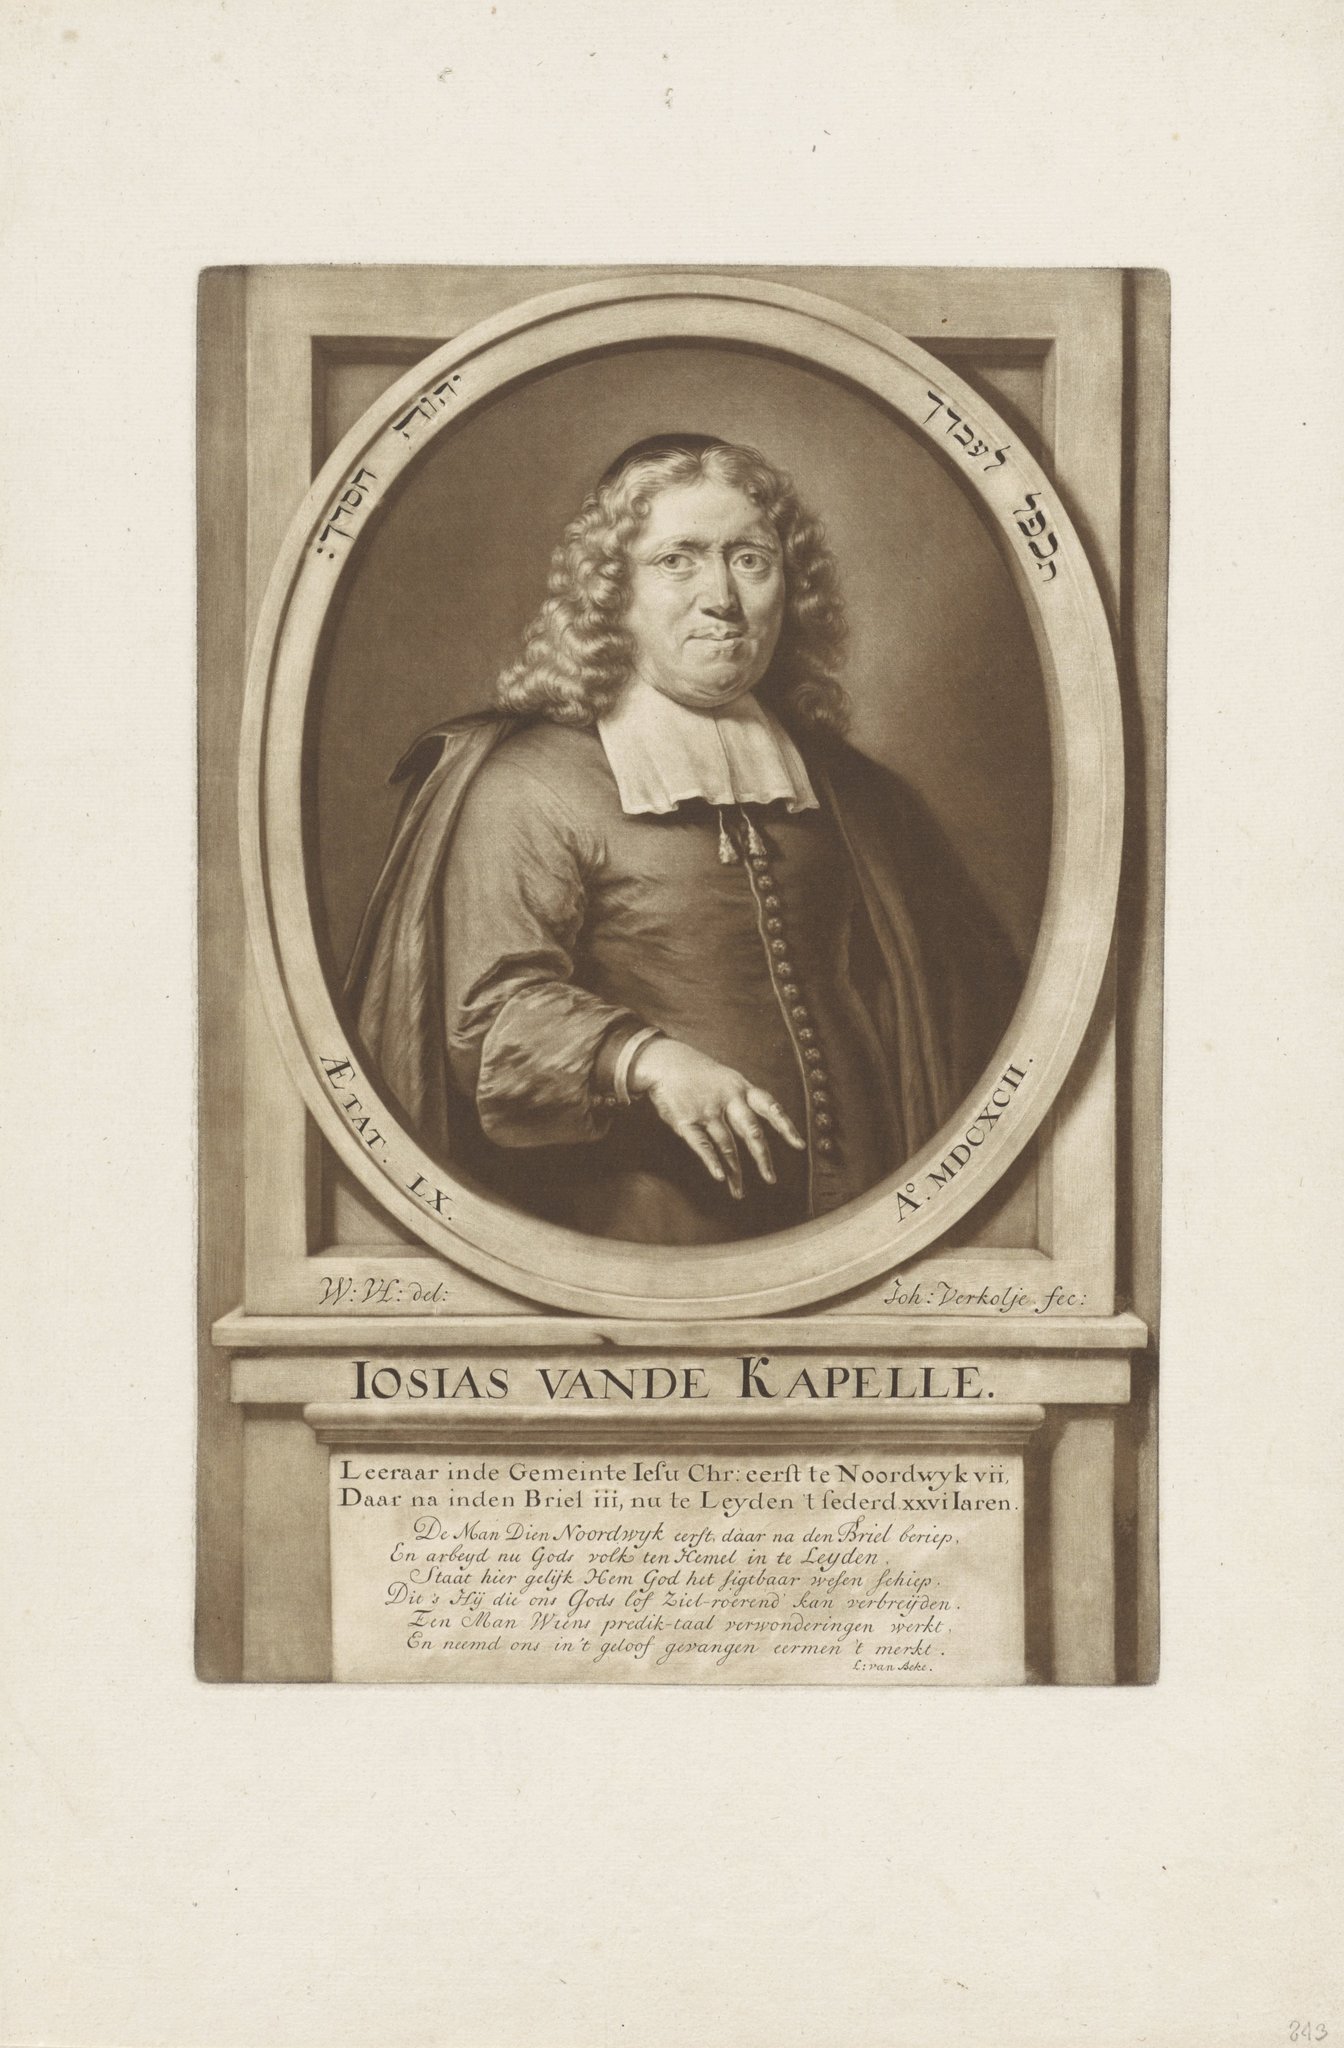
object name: print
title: Portret van de predikant Josias van der Kapelle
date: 1692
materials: paper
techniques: mezzotint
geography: delft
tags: predikant, josias van der kapelle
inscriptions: collector's mark: Lugt 240